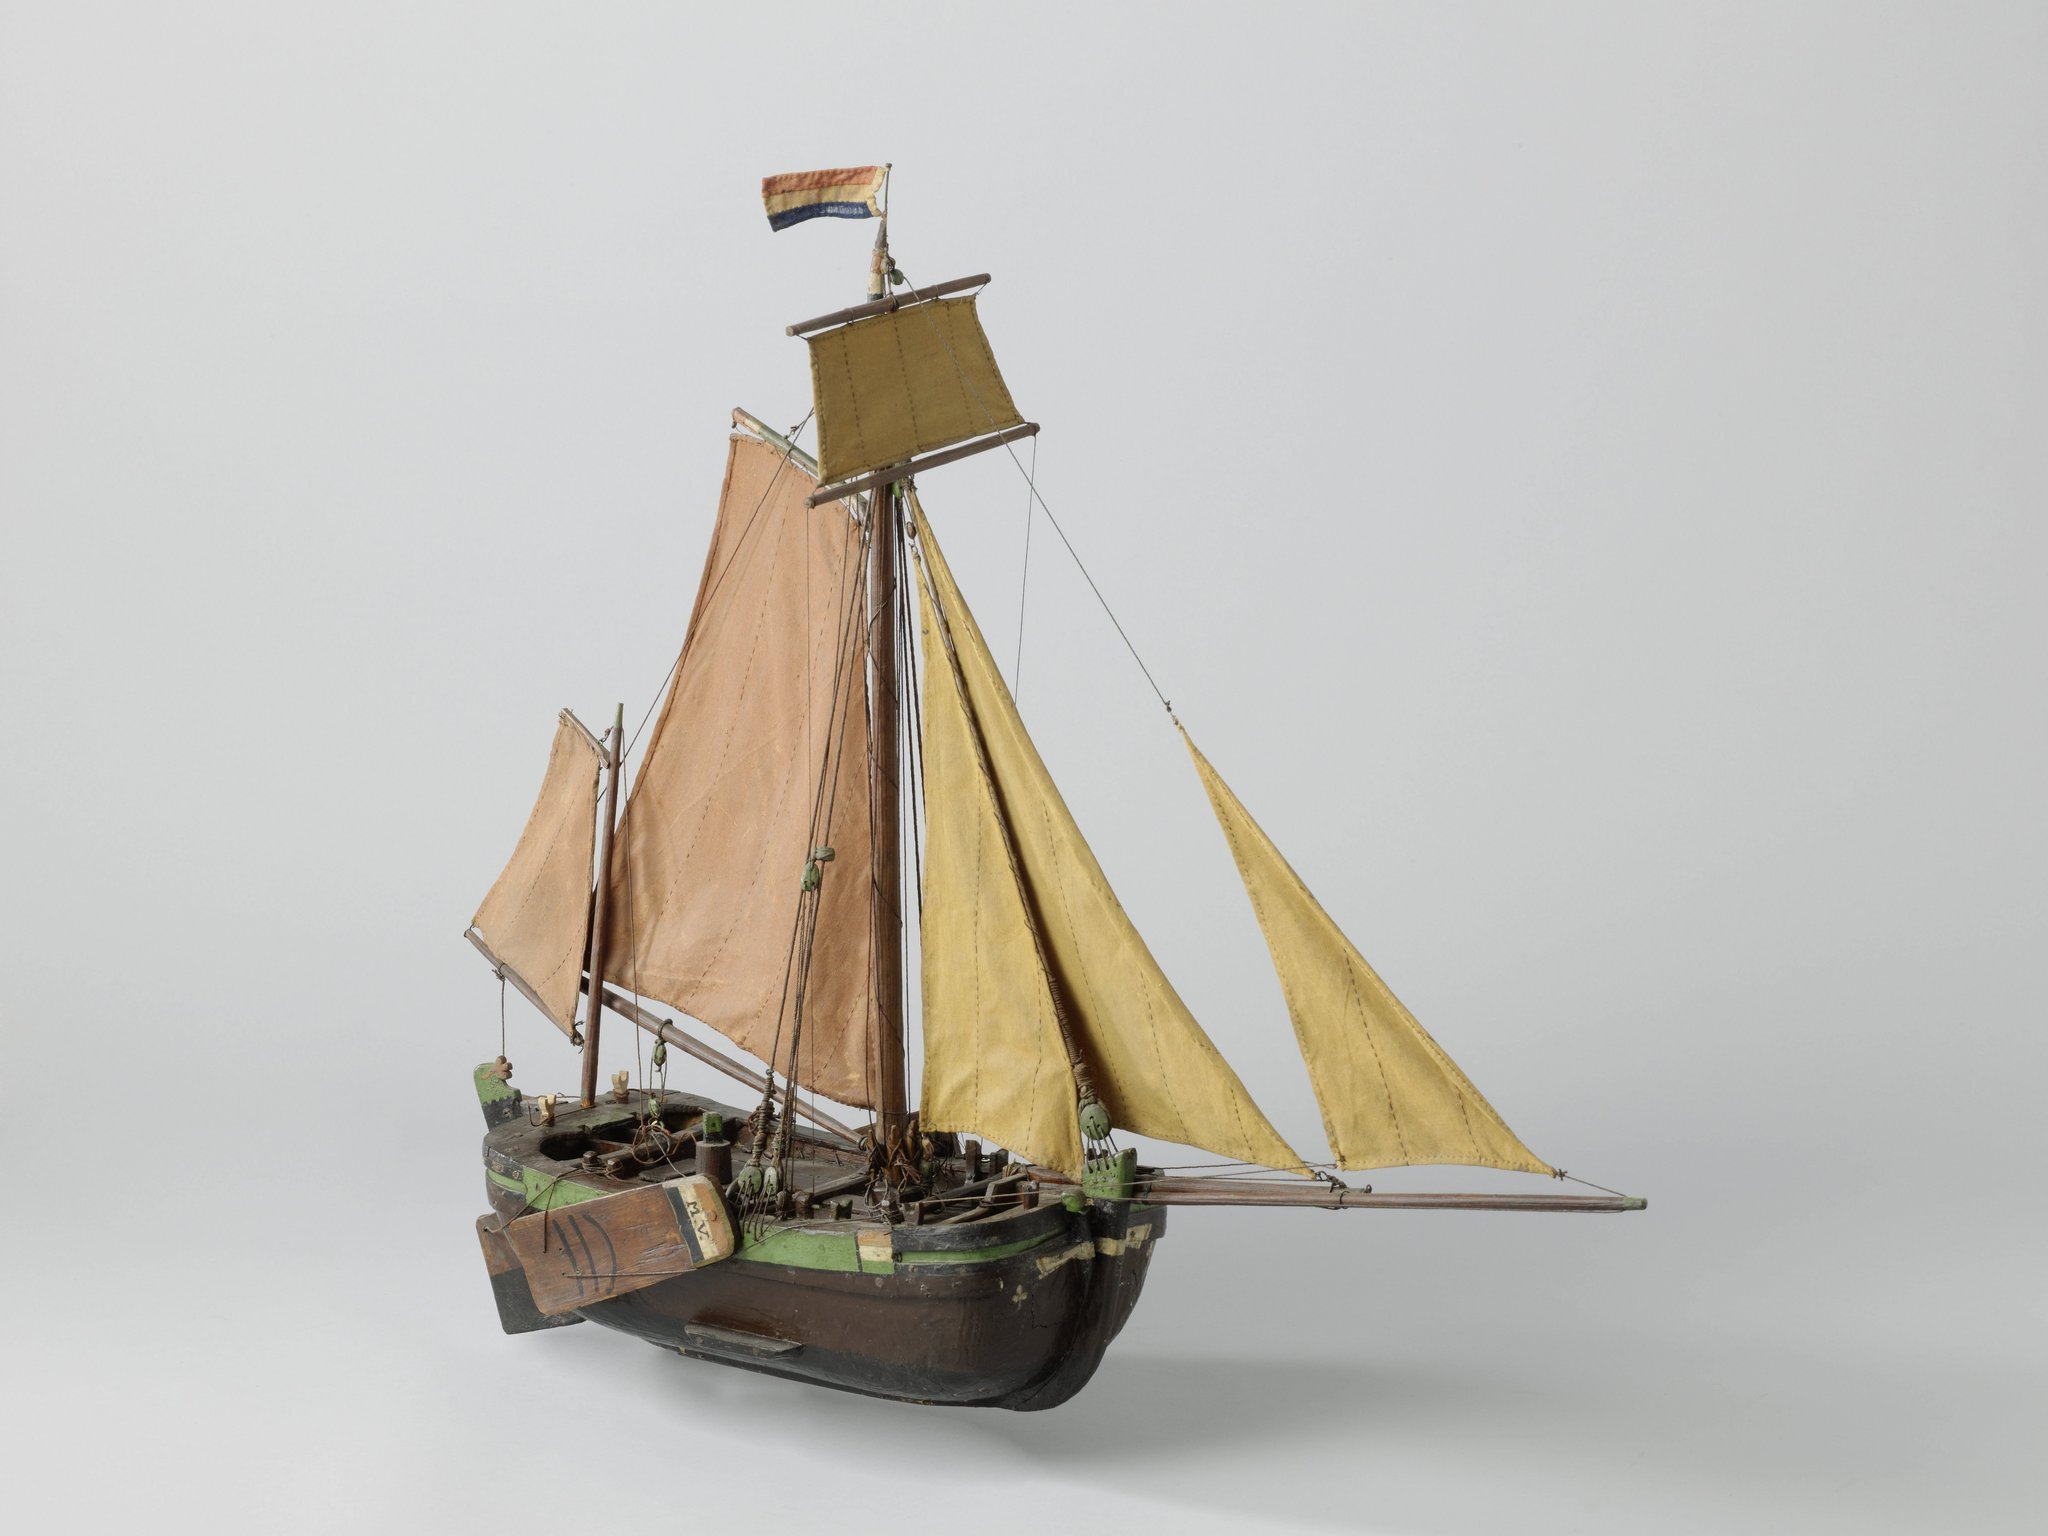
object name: fully rigged model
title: Model of a Pinky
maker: Anonymous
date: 1850-1870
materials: paint, fiber, textile, wood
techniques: polychromy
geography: netherlands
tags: scheveningen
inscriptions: : ‘M.V.’